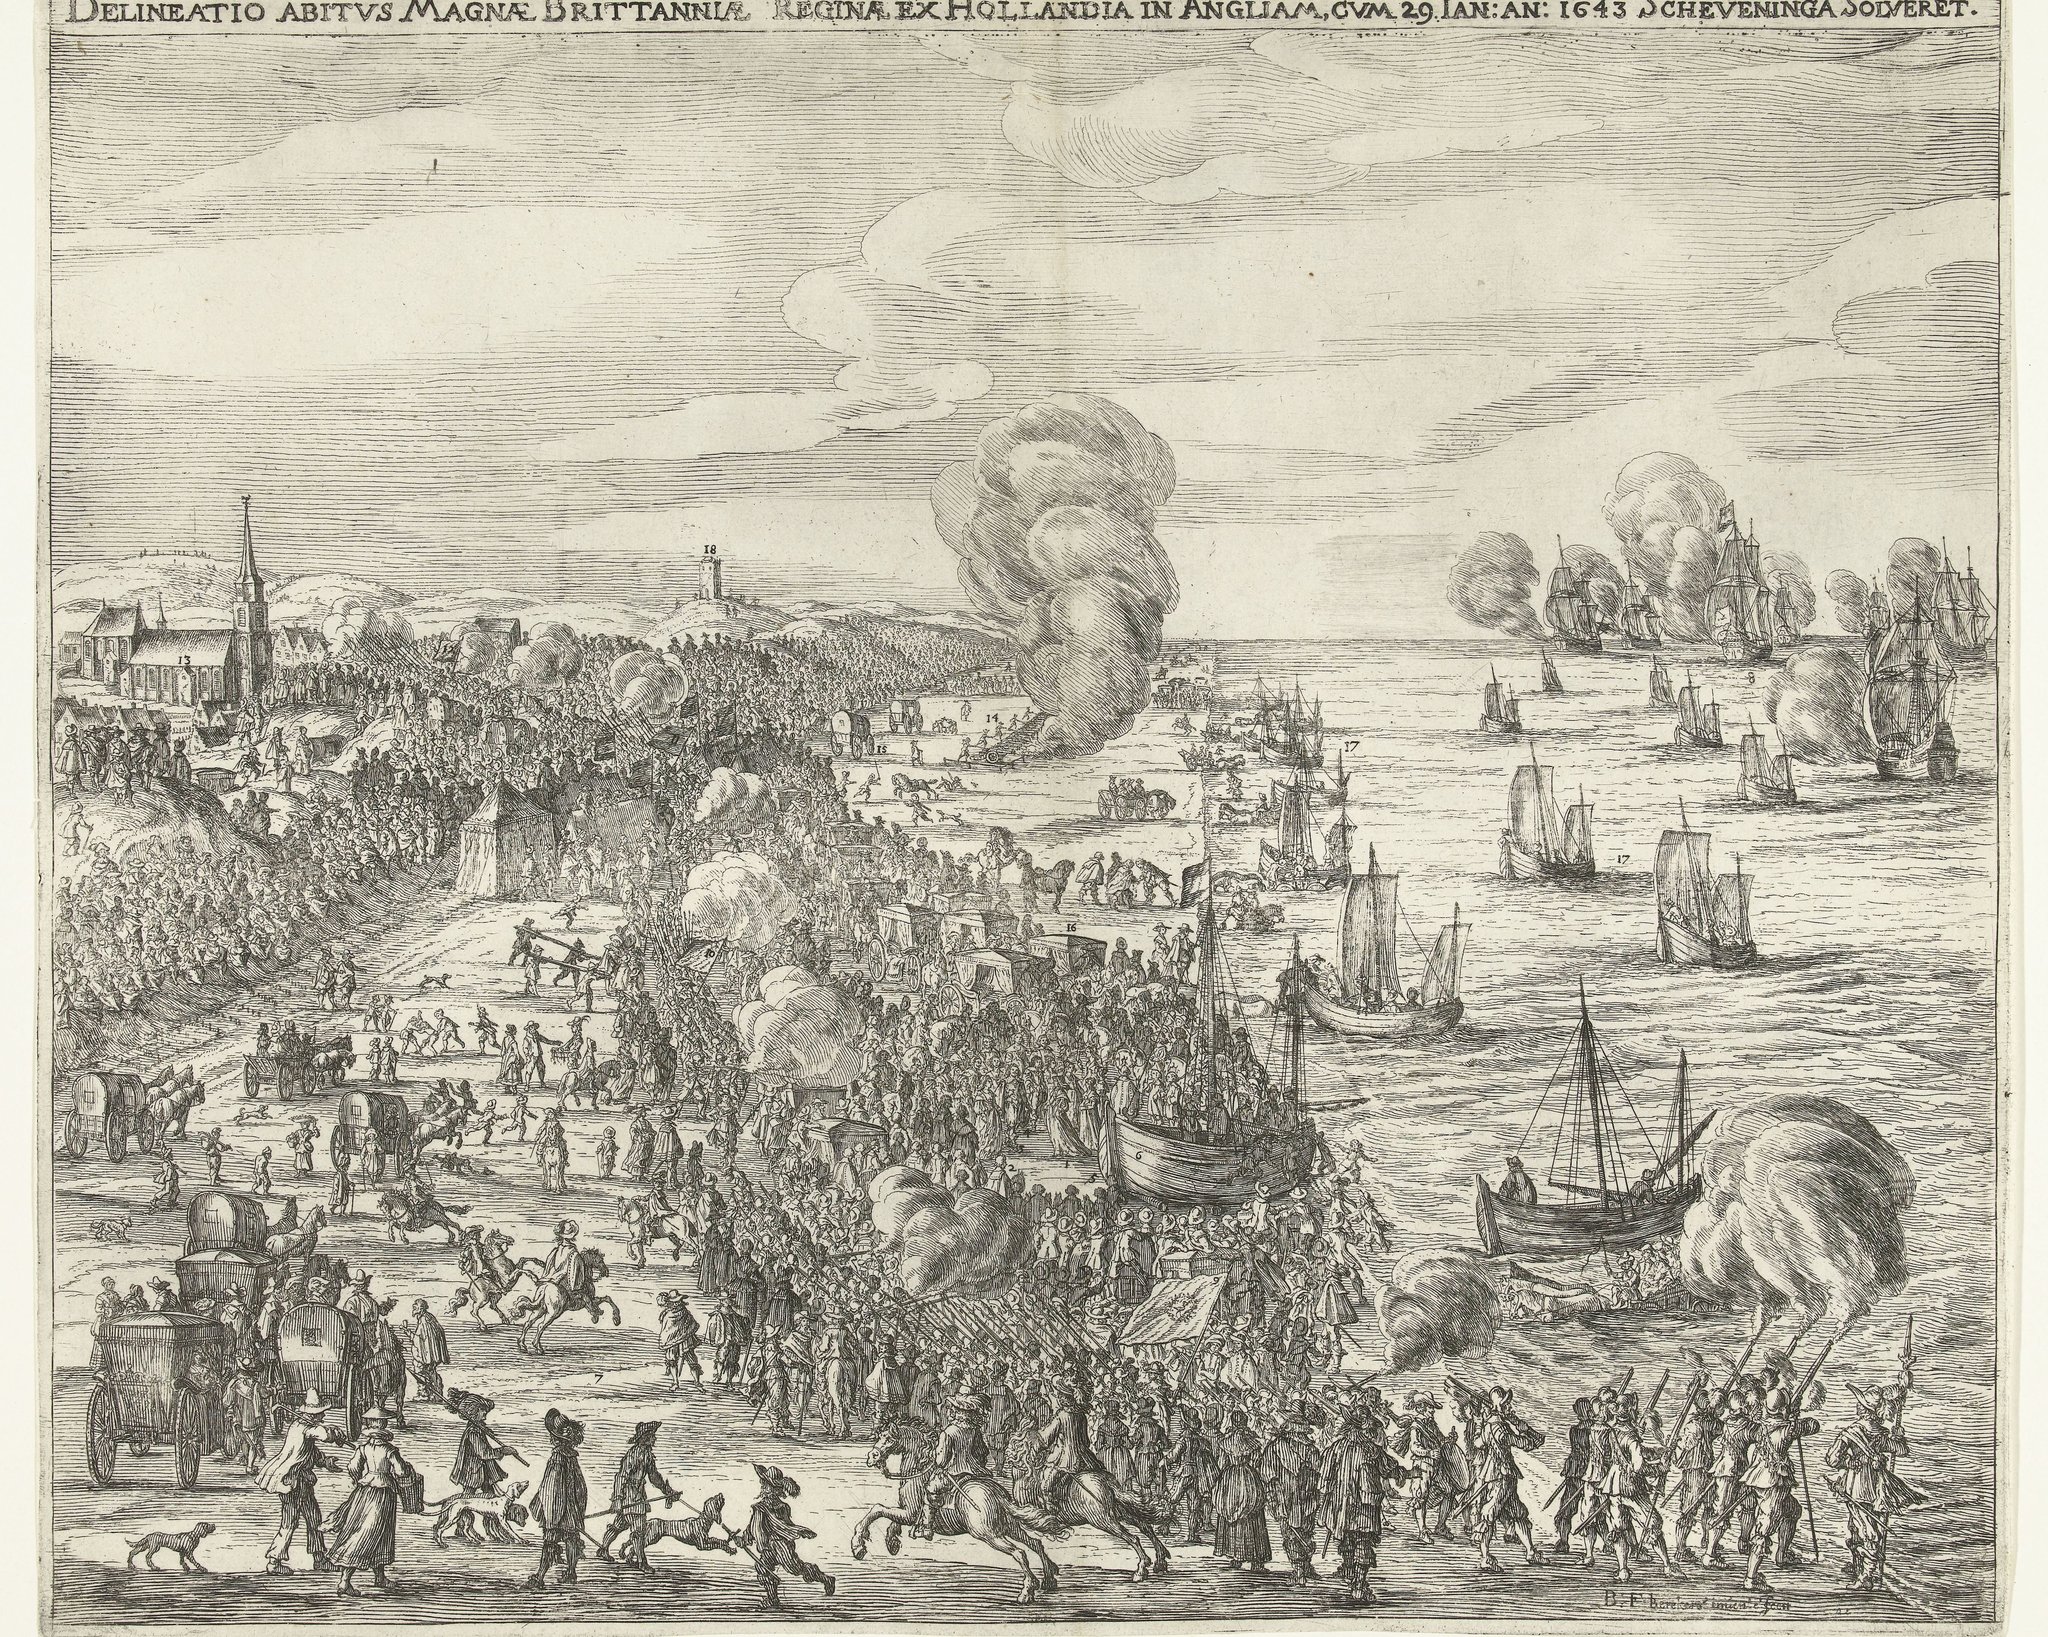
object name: print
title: Vertrek van koningin Henrietta Maria vanuit Scheveningen naar Engeland, 1643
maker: balthasar florisz. van berckenrode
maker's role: draughtsman, print maker, publisher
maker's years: 1591-1645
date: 1643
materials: paper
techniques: etching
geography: the hague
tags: henriëtta maria van frankrijk (koningin van engeland, schotland en ierland), delft, frederick henry (prince of orange), william ii (prince of orange), london, mary henrietta stuart, departure ~ travelling (+ propulsion of vehicle, ship, etc. by wind)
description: Het vertrek van de Engelse koningin Henrietta Maria vanuit Scheveningen naar Engeland, 29 januari 1643. Op het strand een grote menigte met wagens, ruiters en toeschouwers, links in de verte het dorp Scheveningen, op het strand de pink die de koningin naar haar schip zal brengen. Op het strand neemt de koningin onder saluutschoten afscheid van Frederik Hendrik, prins Willem en Maria Stuart, koningin Elisabeth van Bohemen en vertegenwoordigers van de Staten-Generaal. Bij de prent behoort een tekstblad.